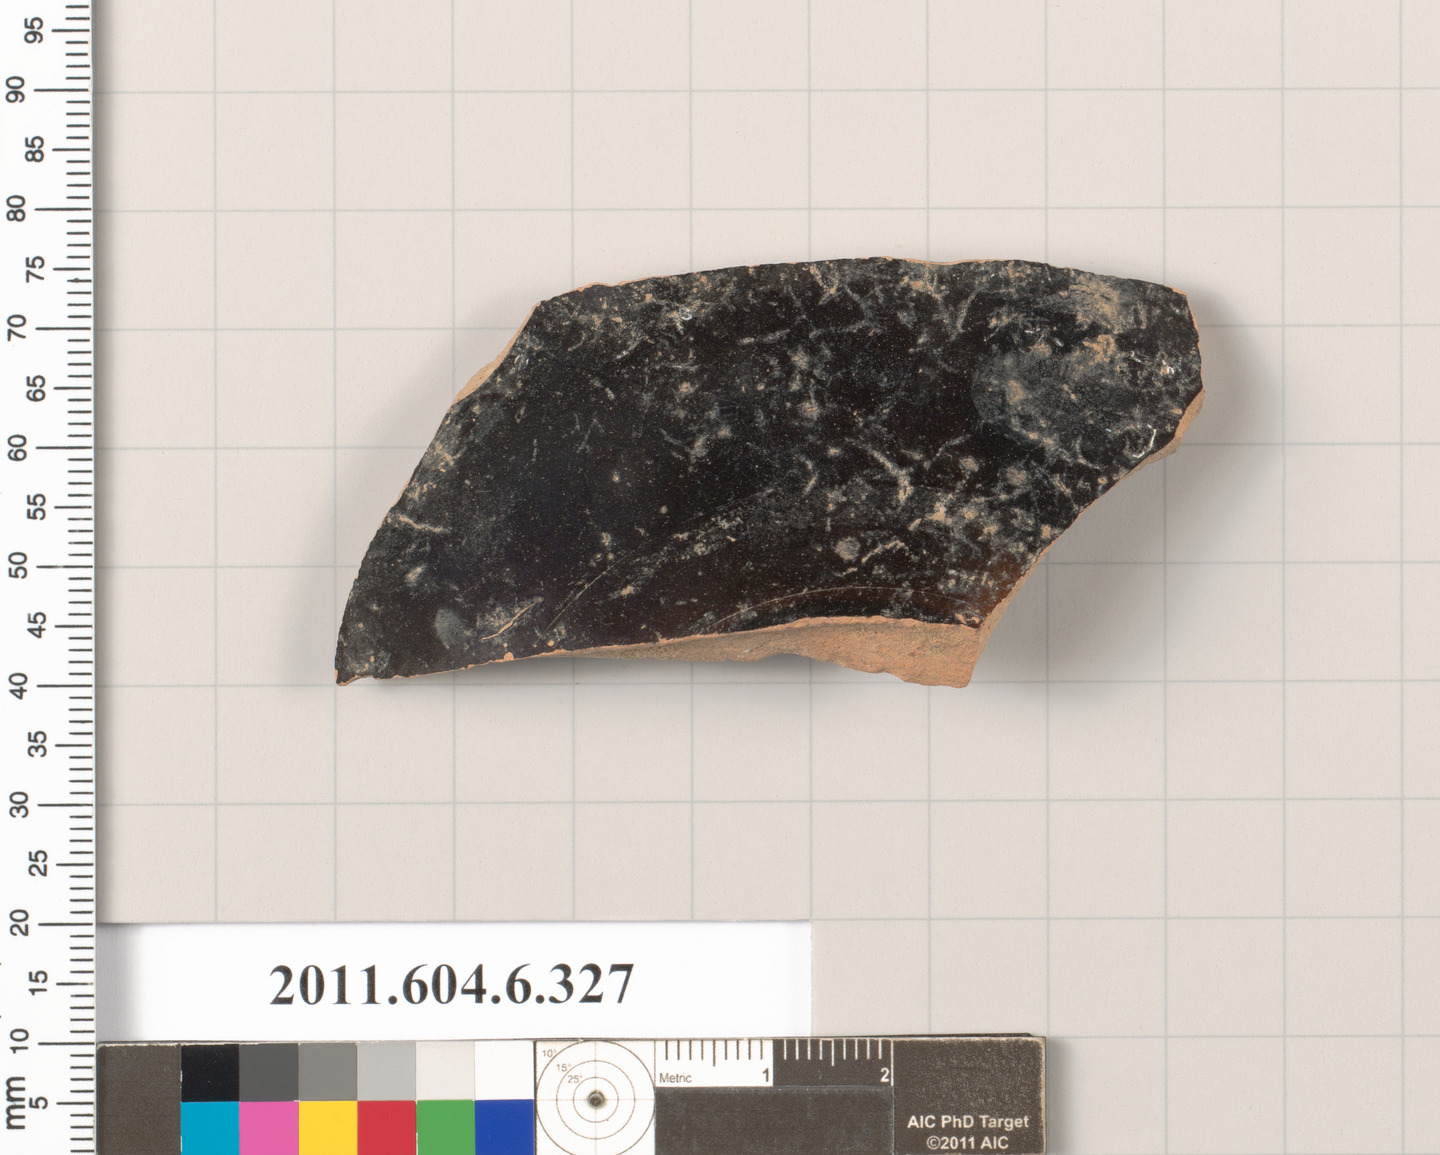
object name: unidentified shape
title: Terracotta fragment of an unidentified shape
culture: greek, attic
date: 600-401 BCE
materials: terracotta